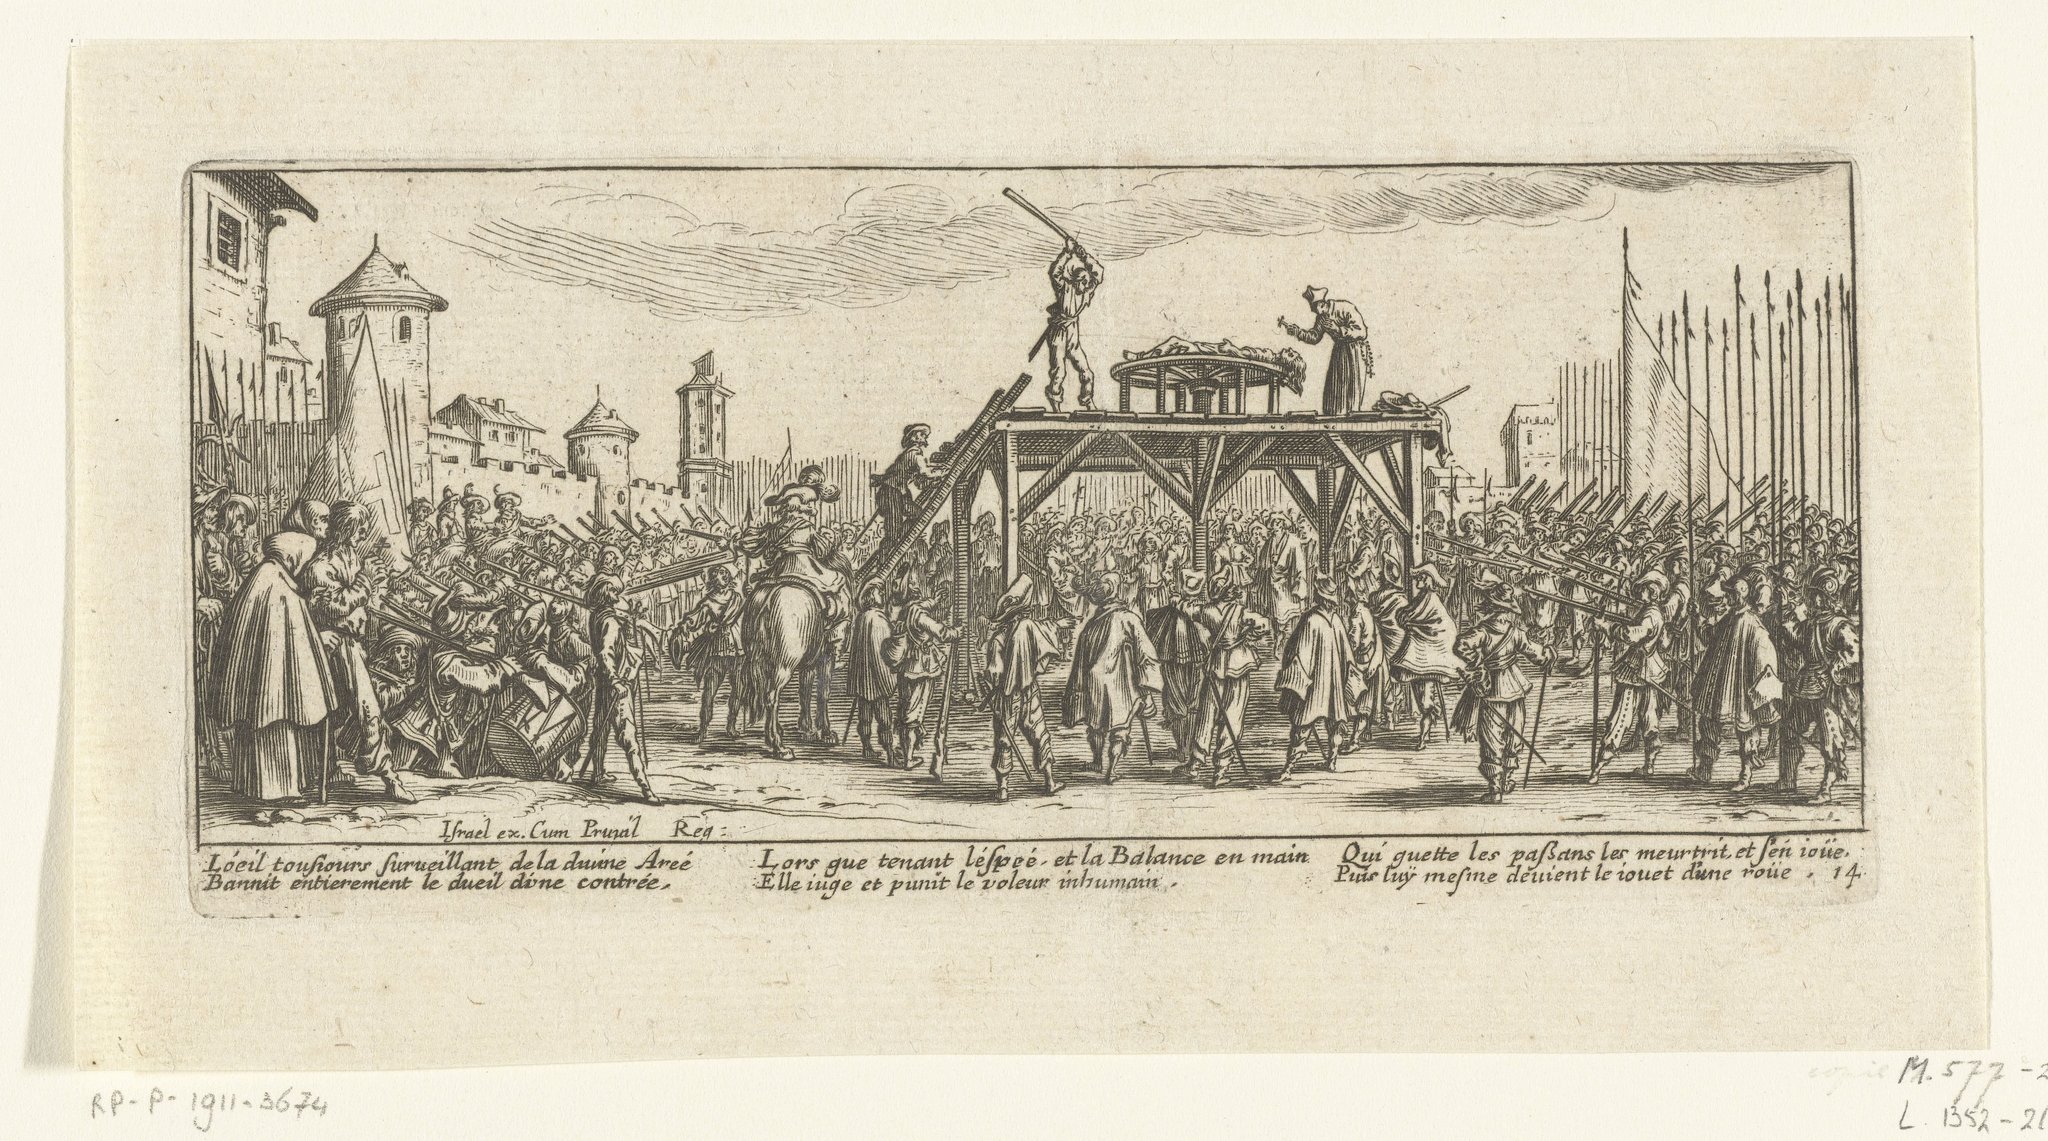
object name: print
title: De gruwelen van de oorlog (groot)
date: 1677-1690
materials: paper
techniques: etching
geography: amsterdam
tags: physical punishment ~ military service, warfare; military affairs (+ outside city-wall or fortress)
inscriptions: collector's mark: Lugt 2228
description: Op een open plek bij een stadsmuur zijn vele soldaten verzameld rond een platform waarop een man geradbraakt wordt. Onder de voorstelling een zesregelig Frans vers. Deze prent is onderdeel van een serie van 17 (18 incl. titelprent) prenten met voorstellingen van diverse soorten ellende die oorlogvoering met zich meebrengt.